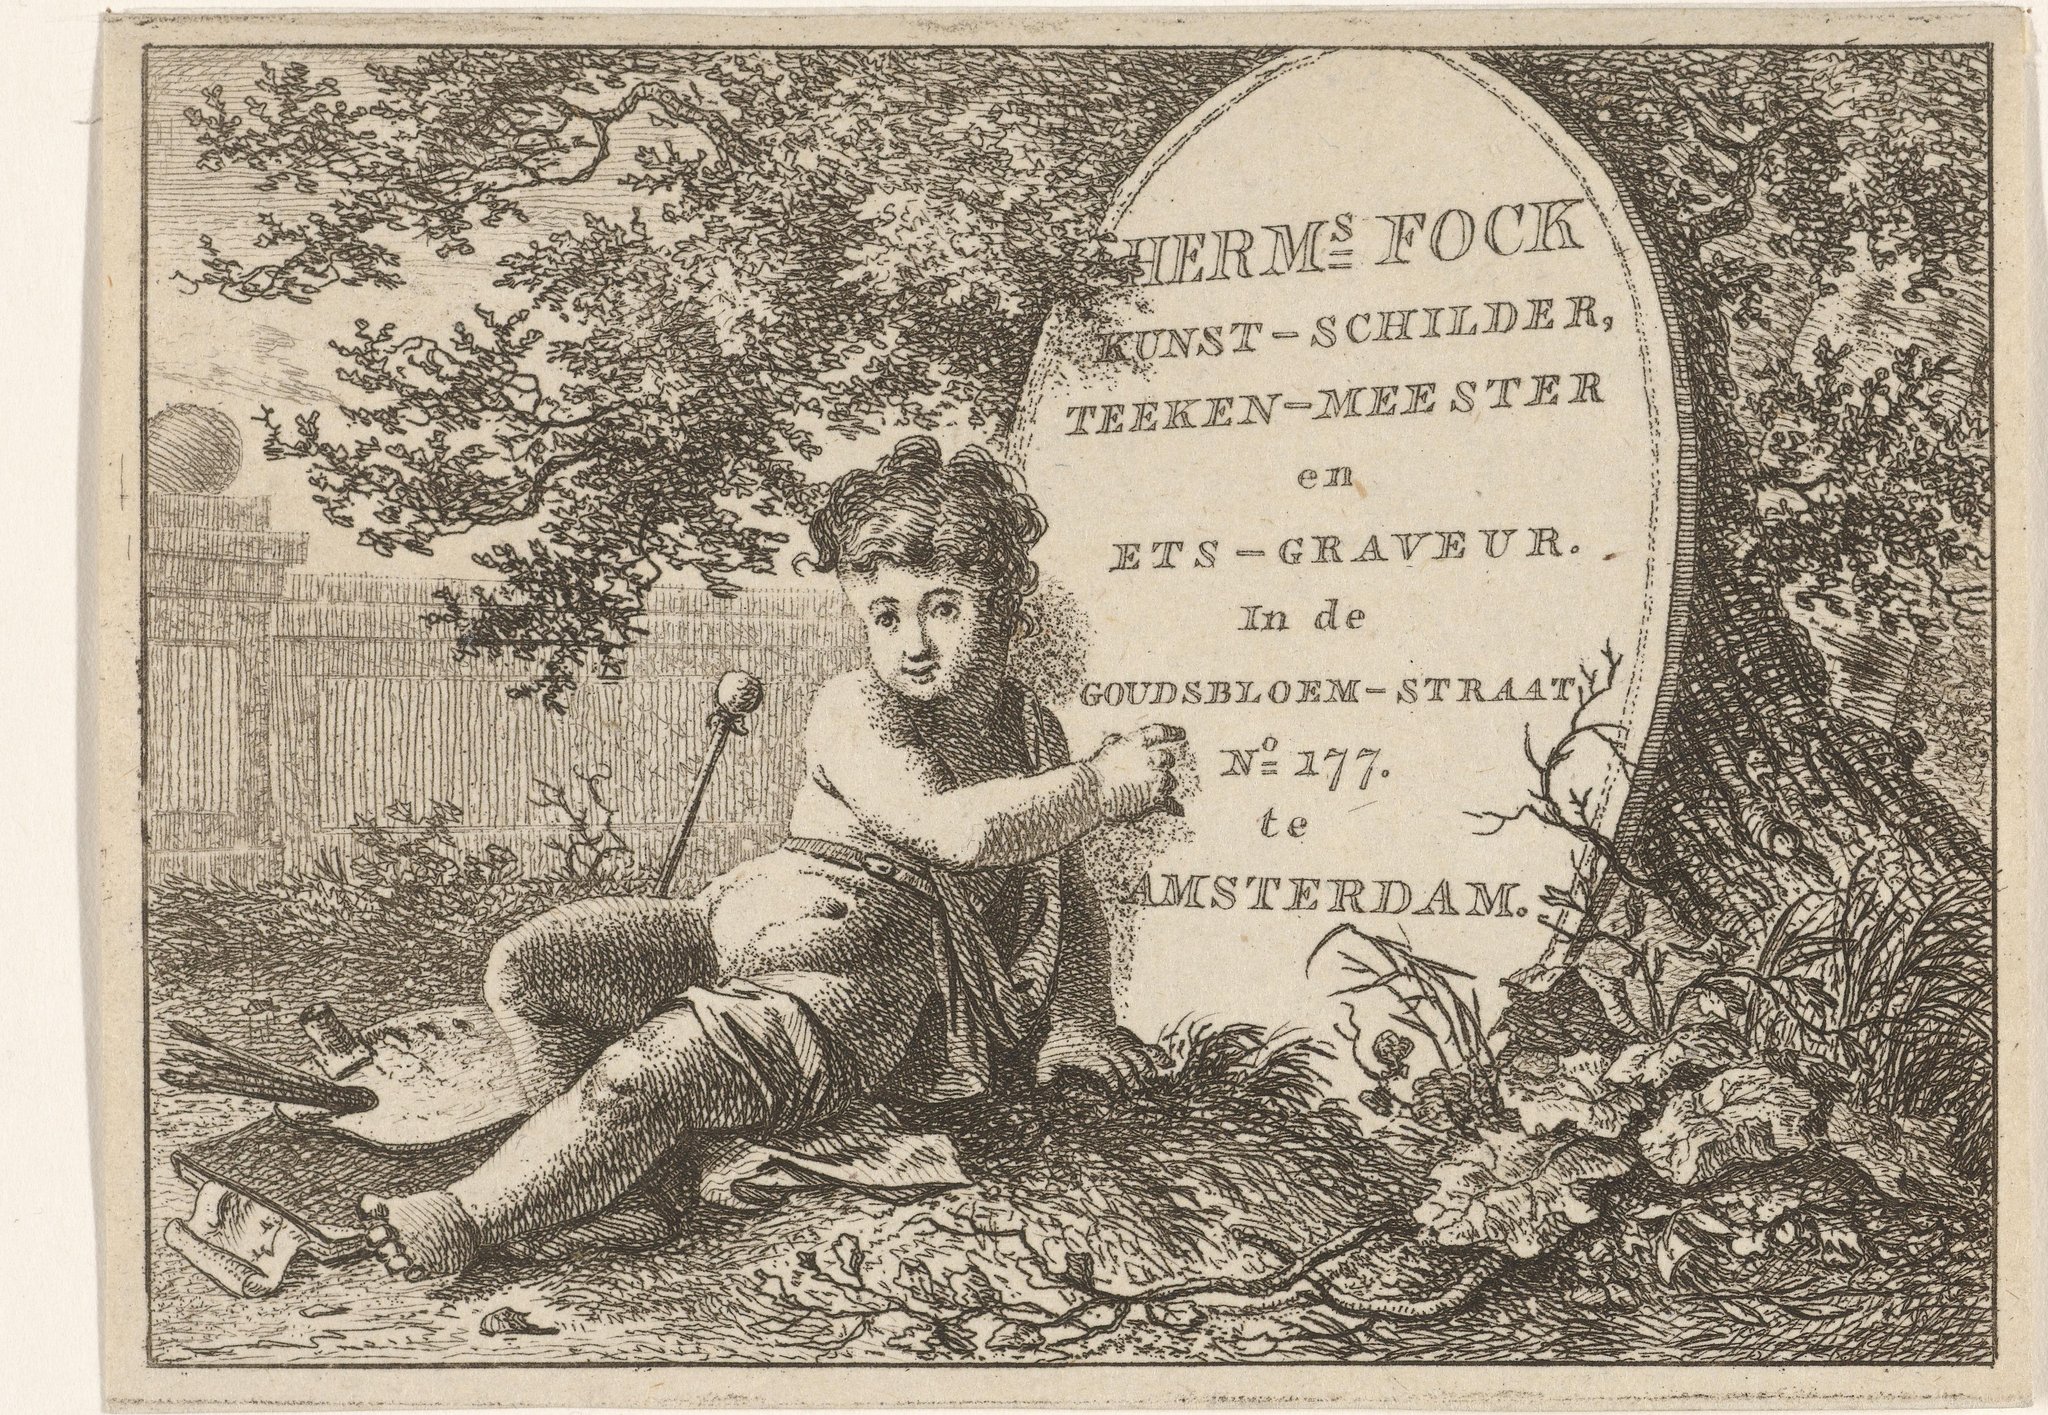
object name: print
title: Visitekaart van Hermanus Fock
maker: hermanus fock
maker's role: conservator, draughtsman, painter, print maker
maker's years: 1766-1822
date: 1781-1822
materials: paper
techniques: etching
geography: amsterdam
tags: personification of (art) academy; 'academia' (ripa) (+ painting materials ~ arts)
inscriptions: collector's mark: Lugt 2228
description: Een putto, als personificatie van de schilderkunst, zit met schildersattributen bij een ovaal cartouche. Het cartouche, waarop een Nederlandse tekst met naam en adres van de prentmaker, staat in het gras, tegen een boom aan.